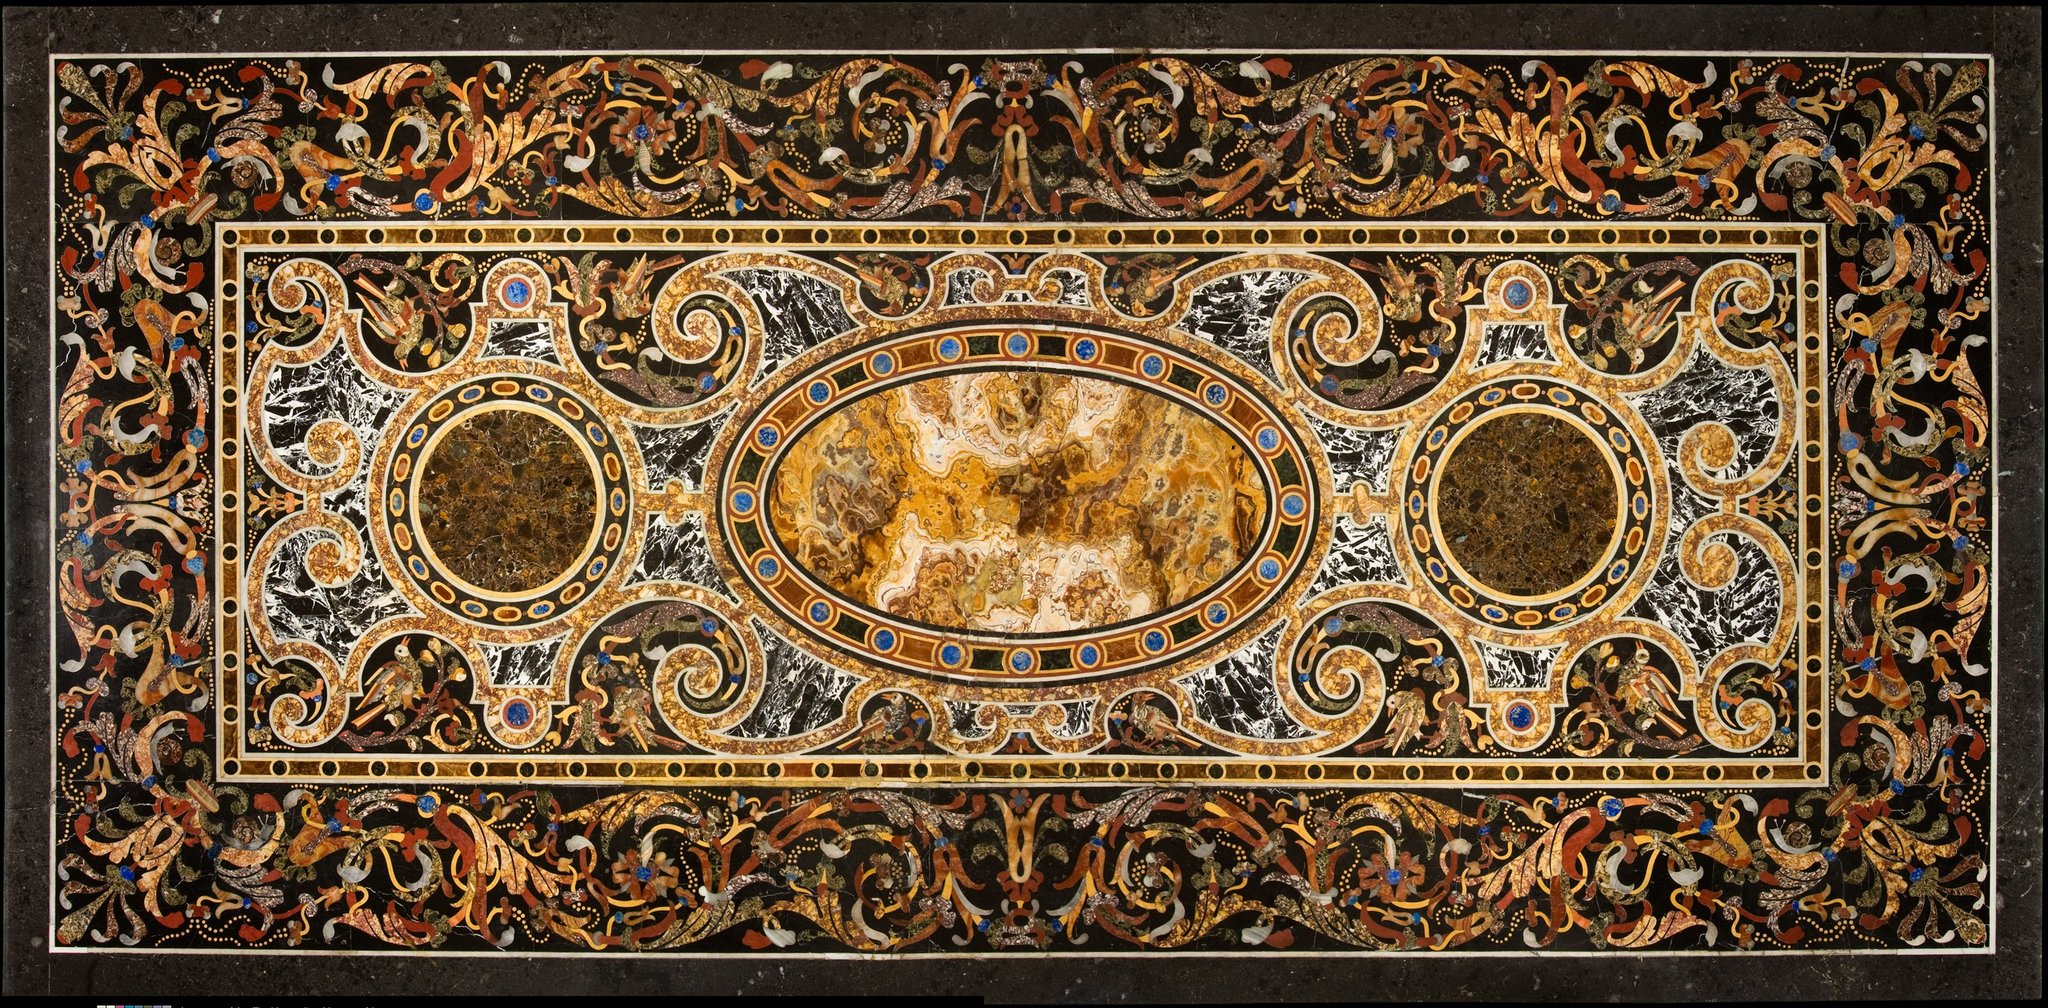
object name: table top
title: Pietra dura table top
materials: alabaster, marble, wood